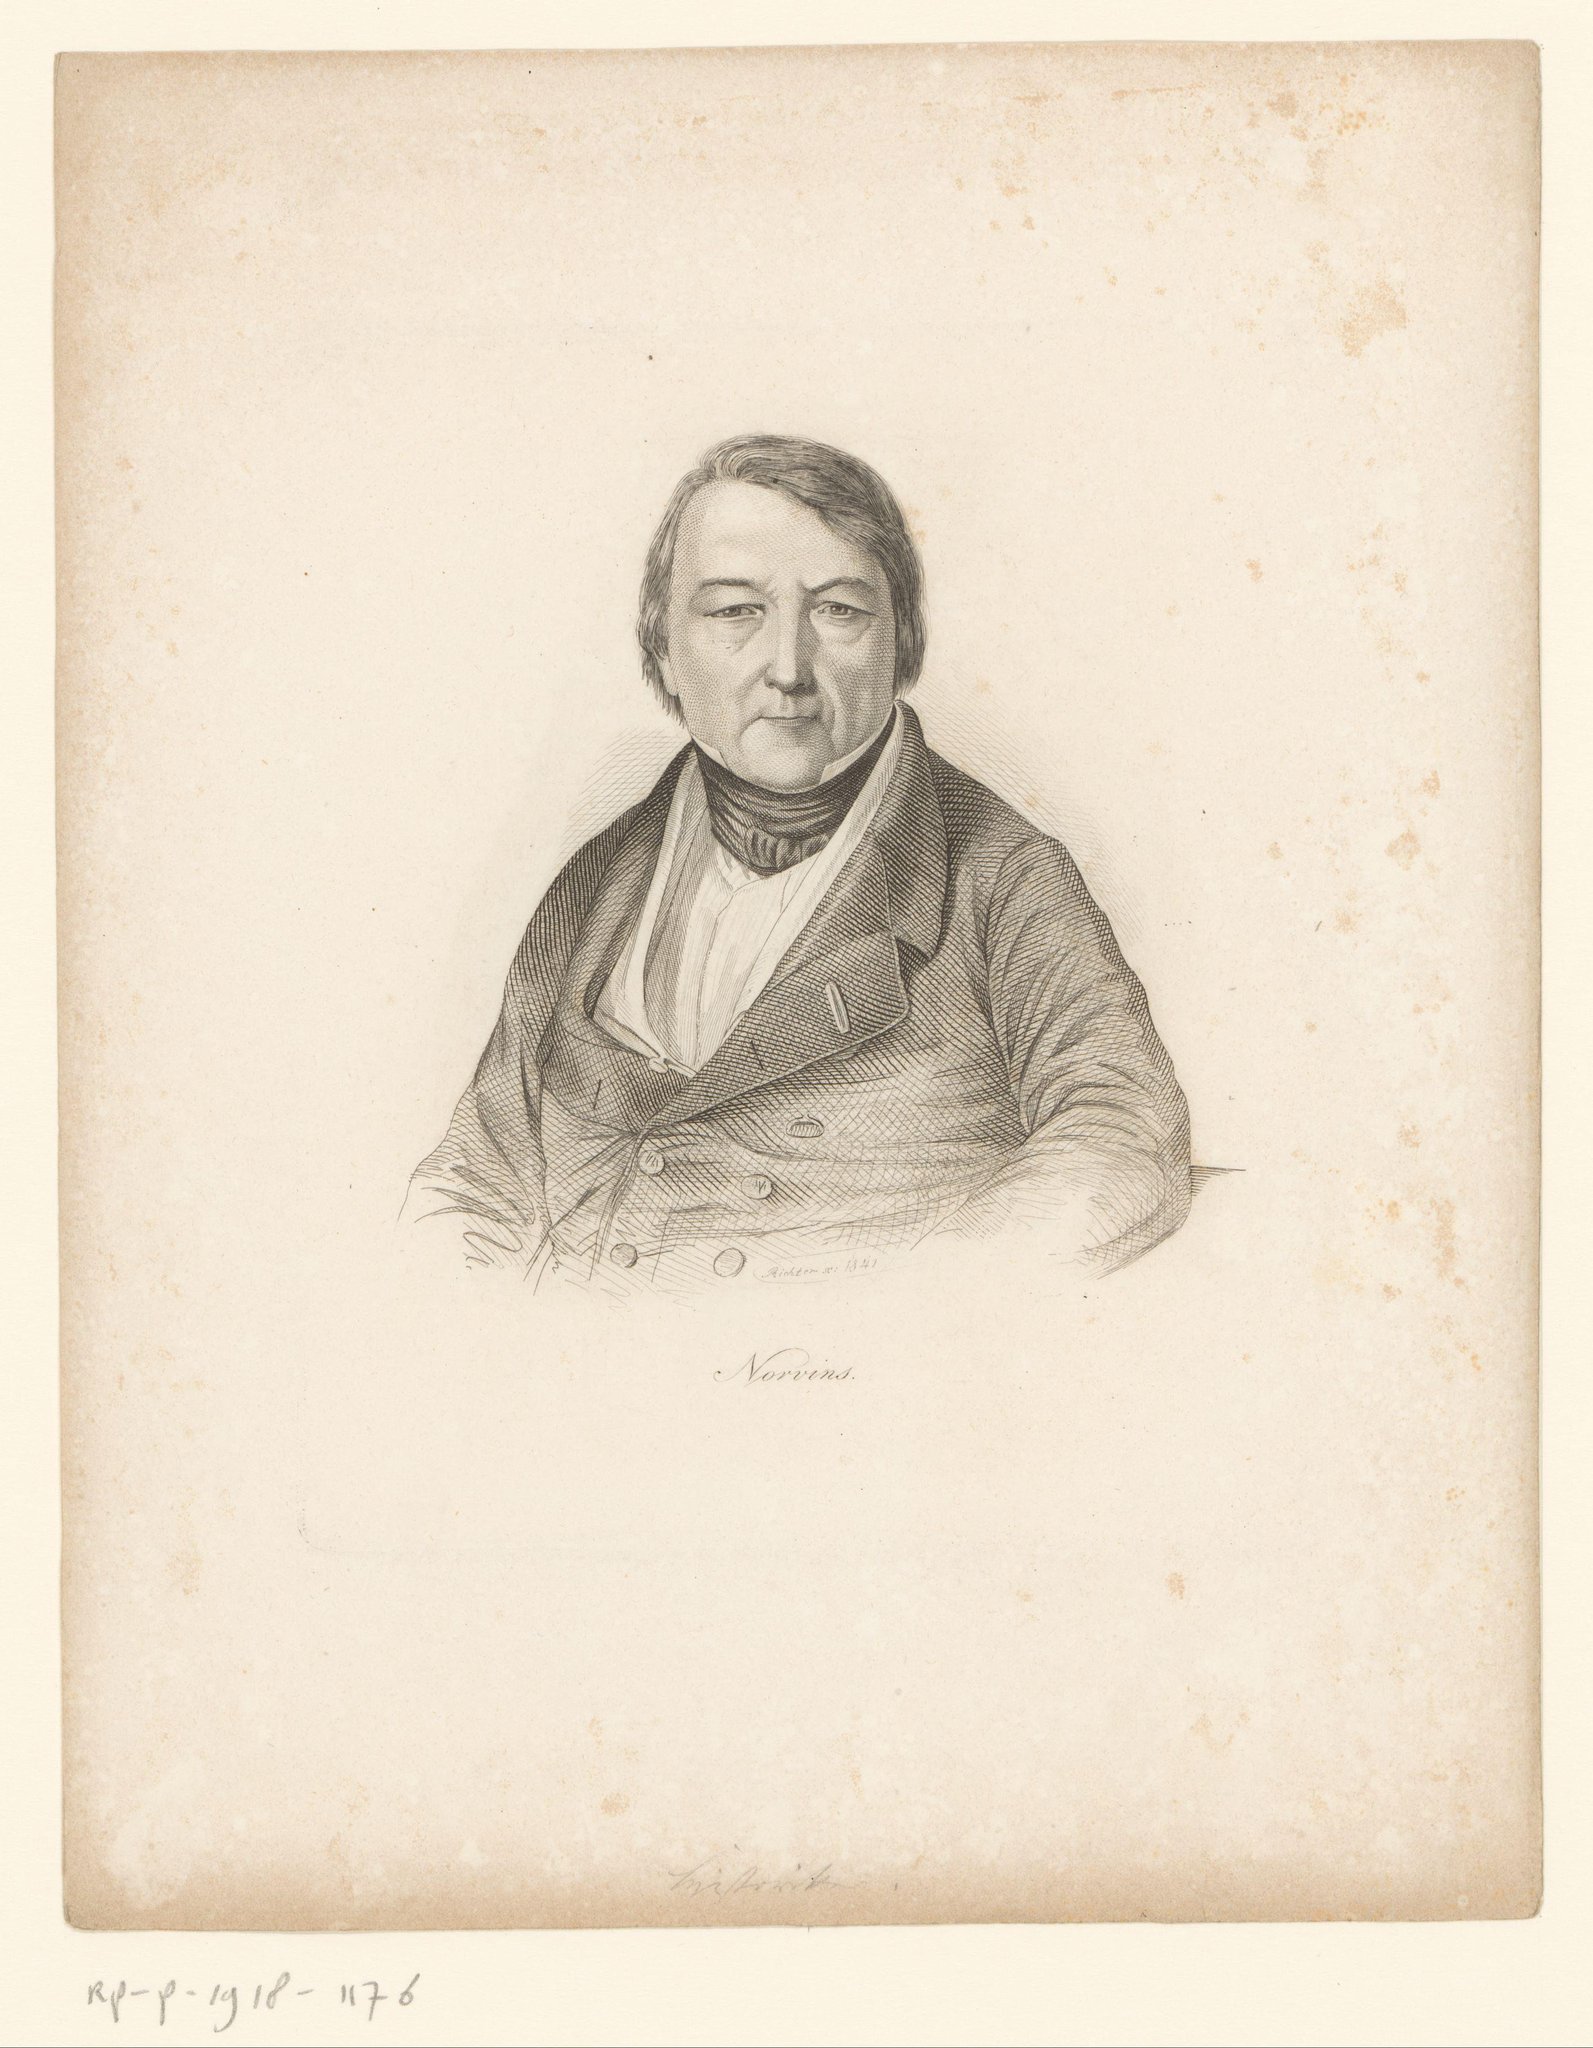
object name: print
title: Portret van Jacques Marquet de Norvins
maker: f. richter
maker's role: print maker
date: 1841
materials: paper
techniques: engraving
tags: france, historical persons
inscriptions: collector's mark: Lugt 2228